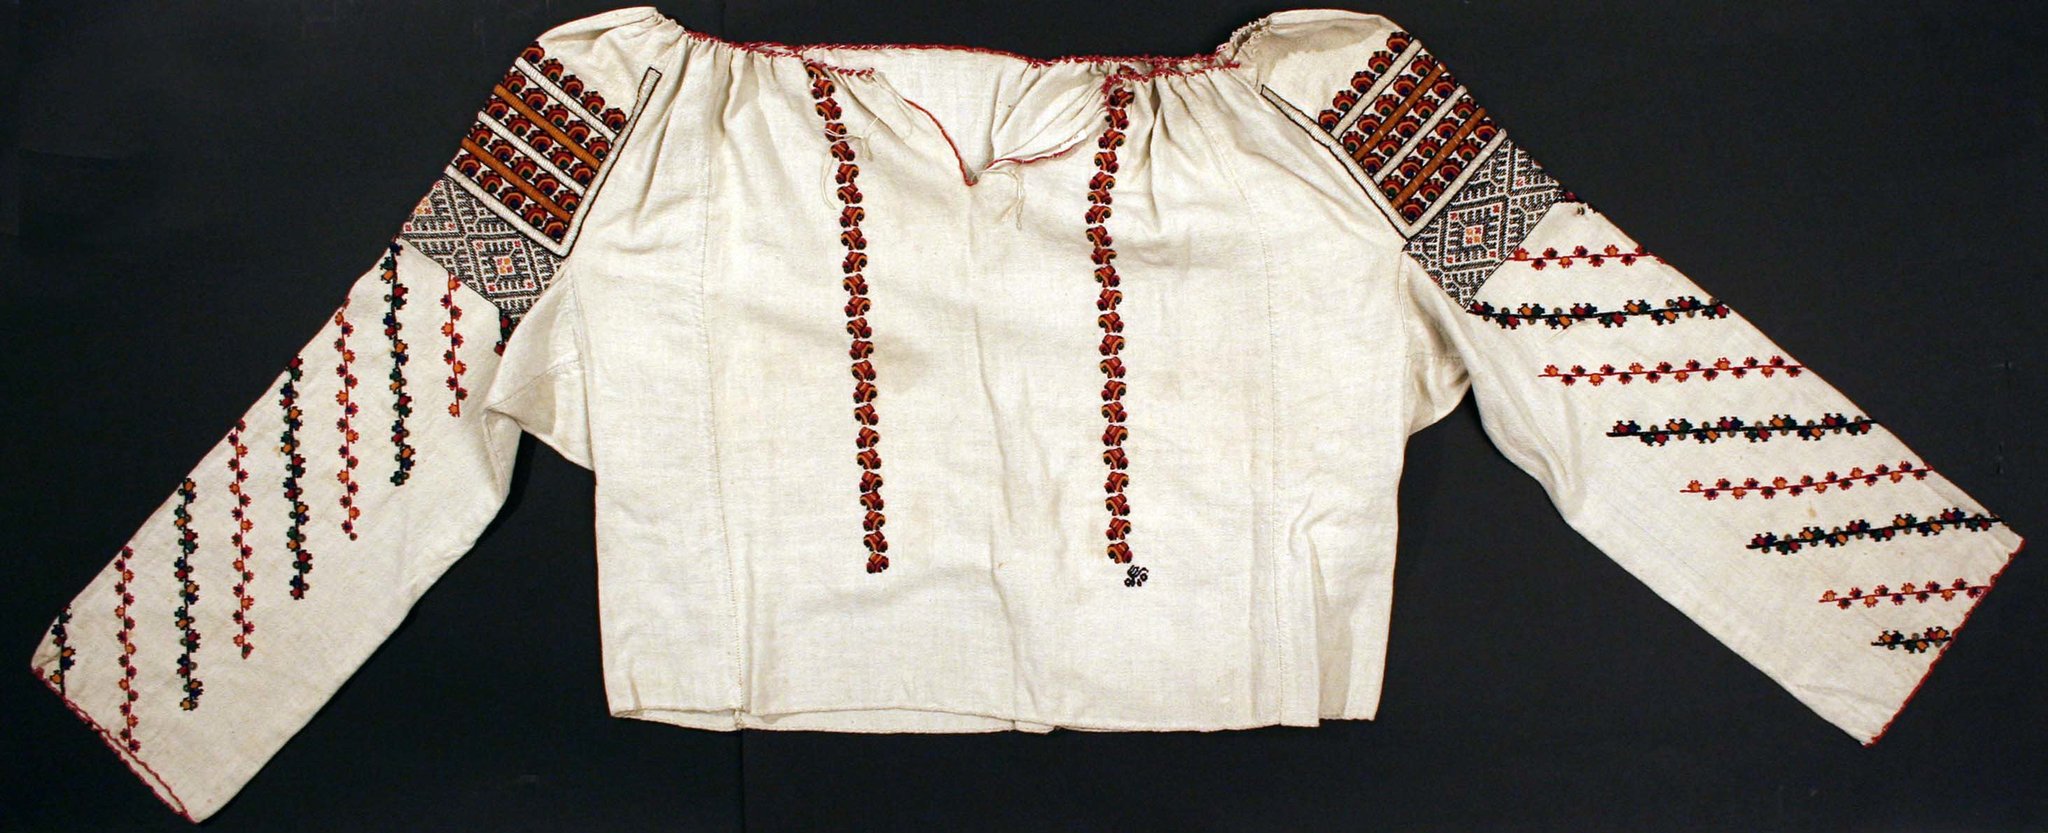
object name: blouse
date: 1801-1833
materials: cotton, glass